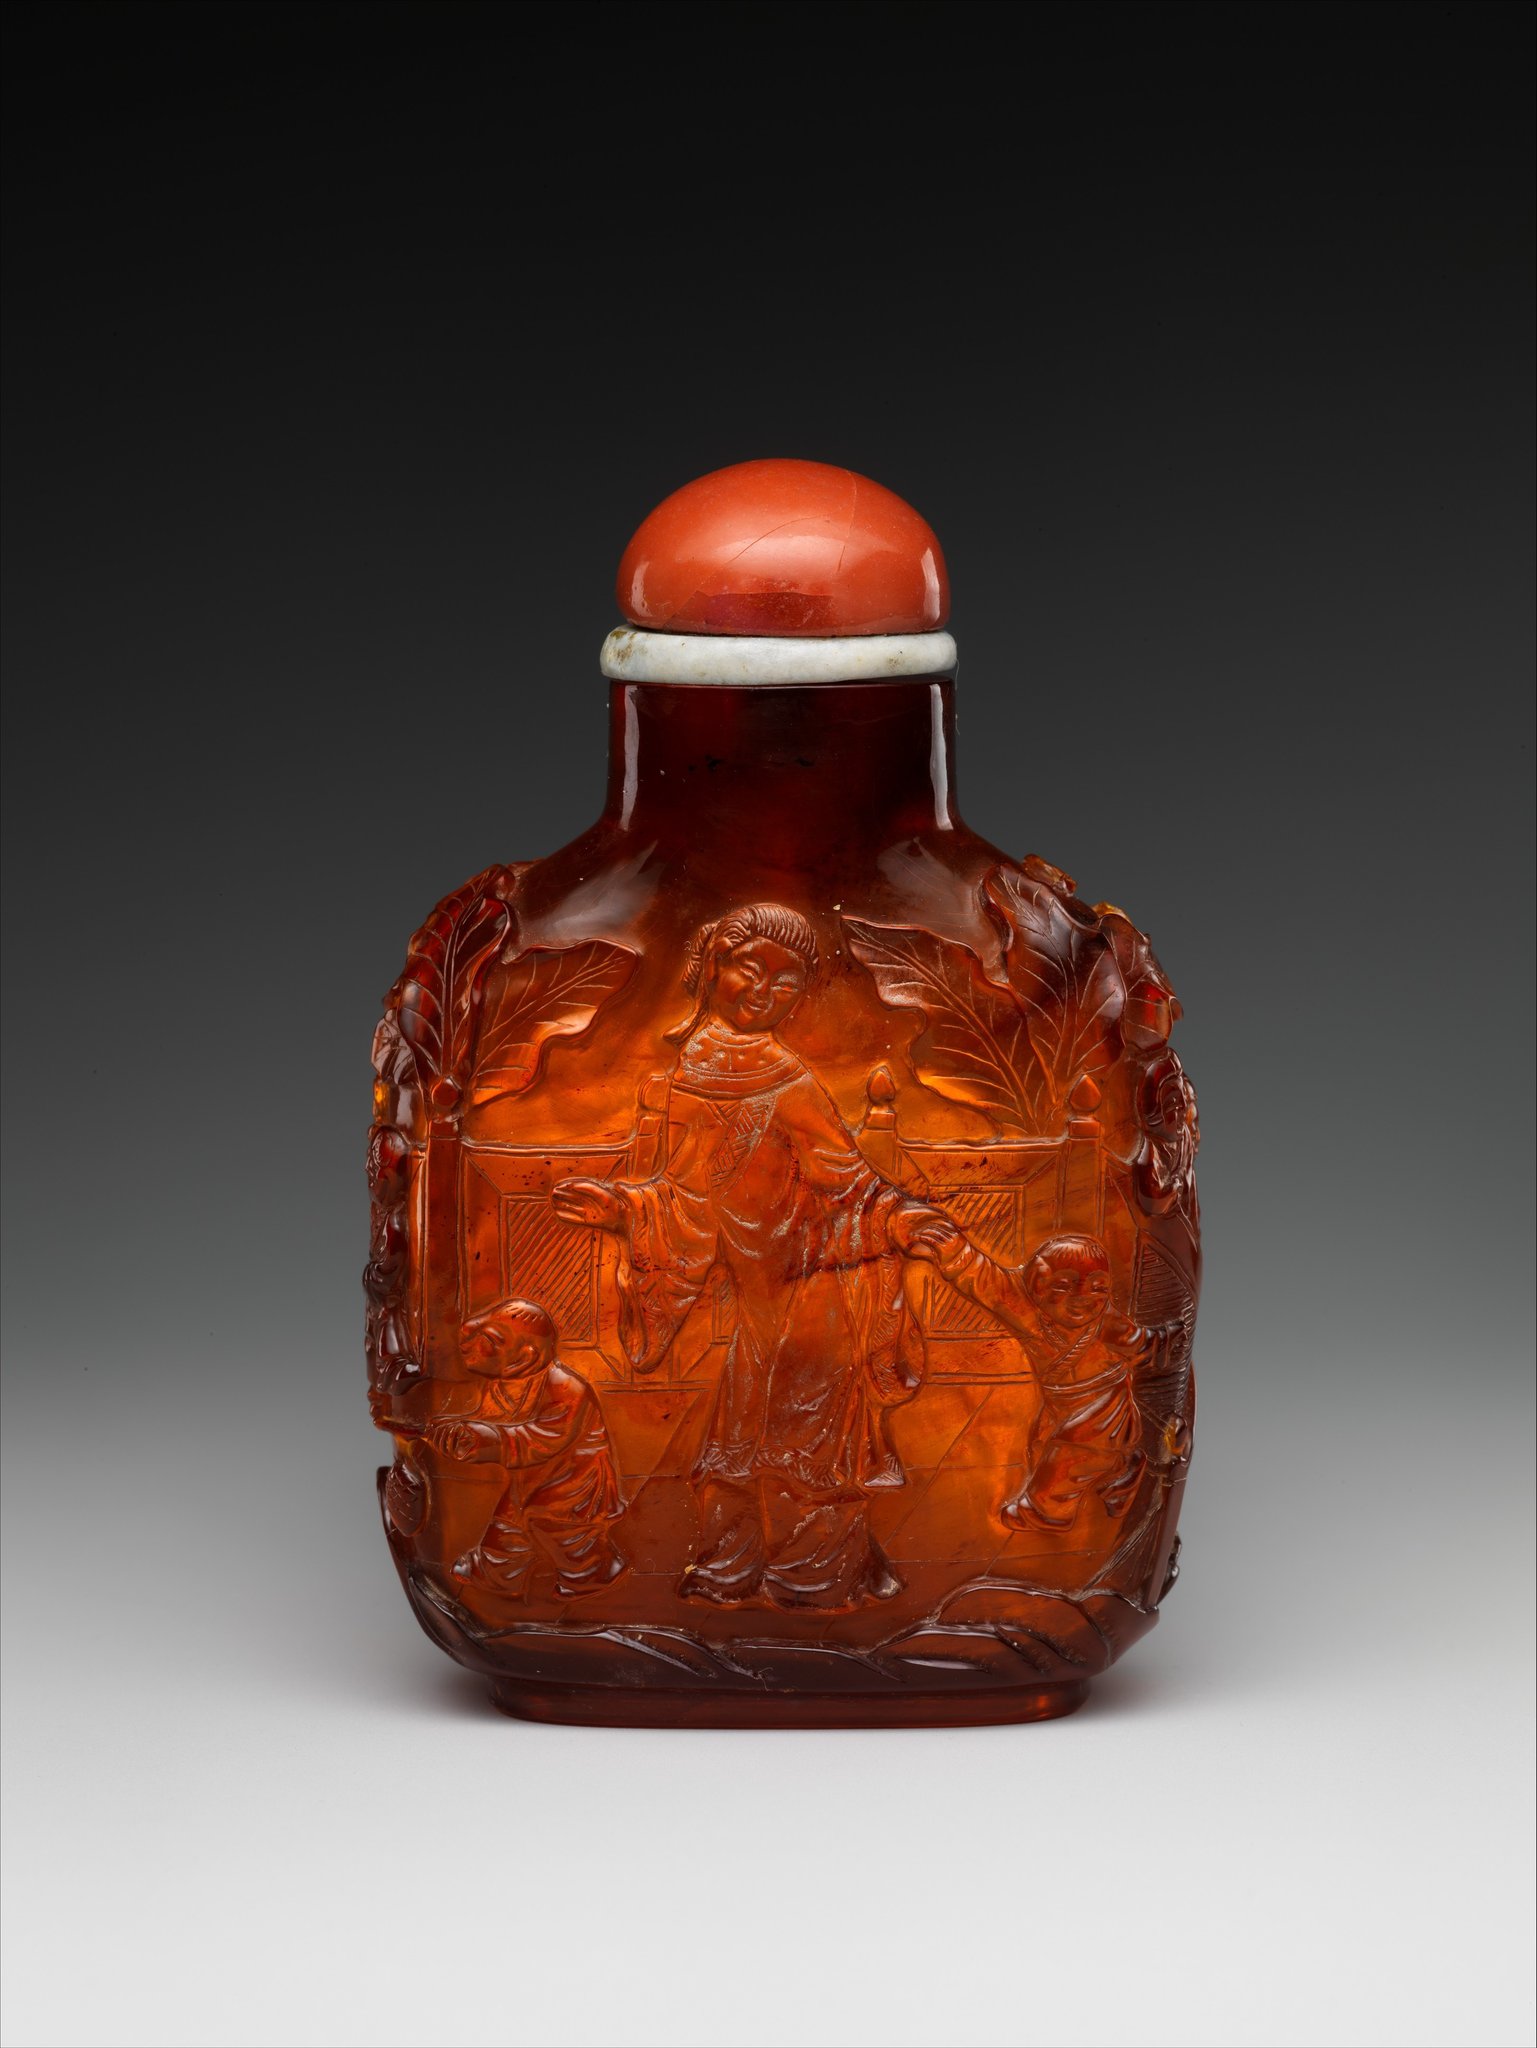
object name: snuff bottle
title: Snuff bottle with women and children in a garden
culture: chinese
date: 1736-1795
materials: amber, coral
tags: children,women